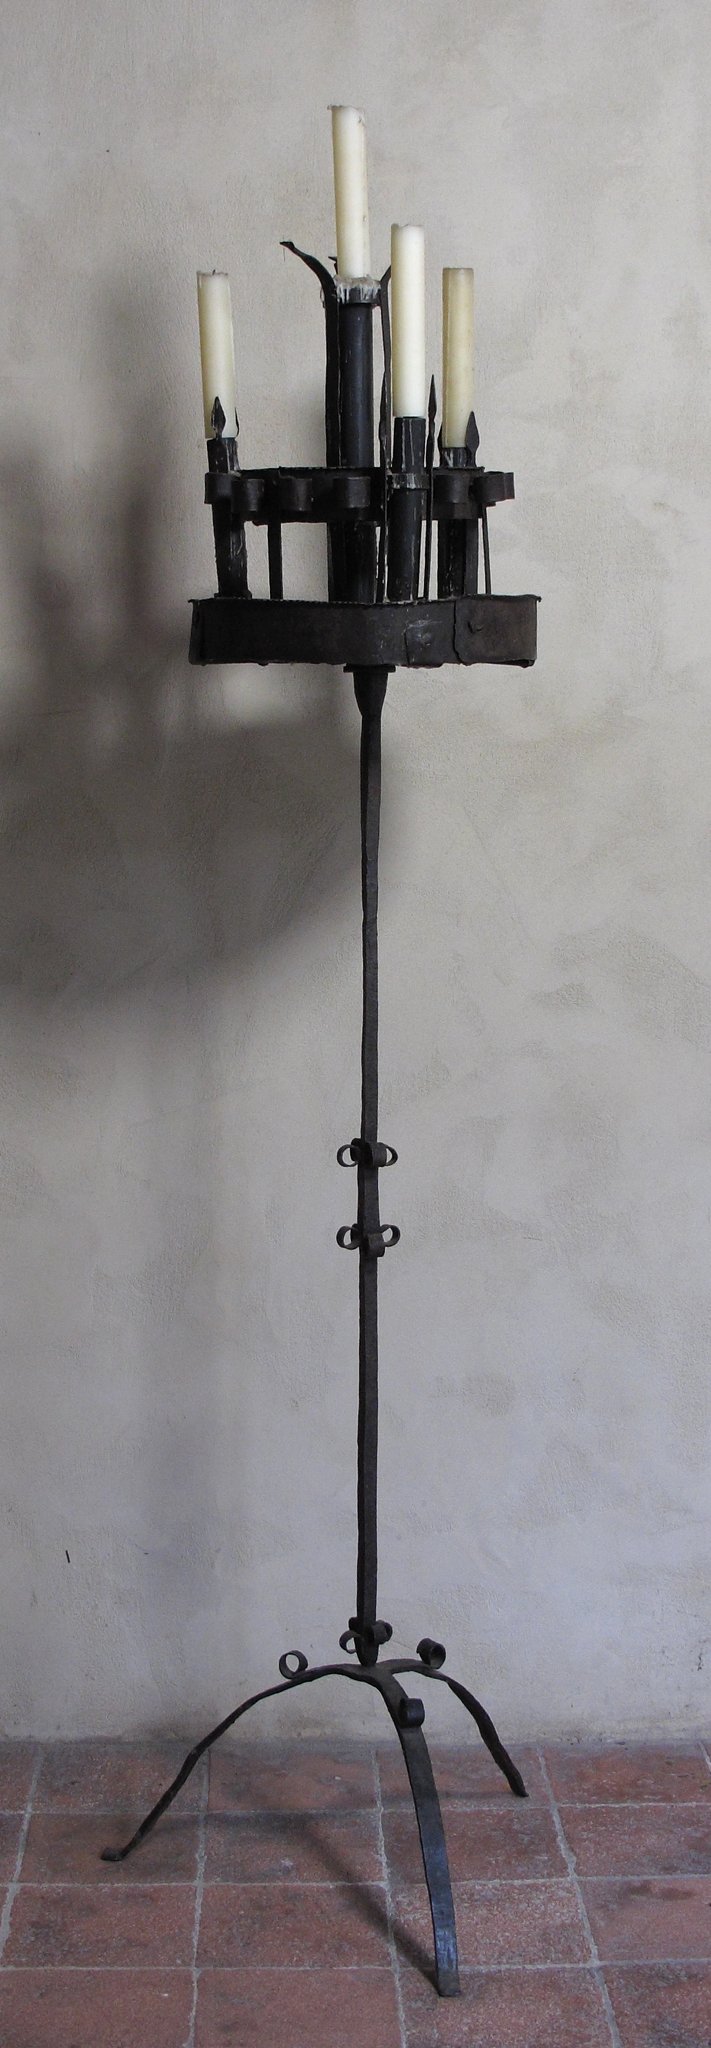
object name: candlestick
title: Pricket Candlestick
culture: european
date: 1501-1600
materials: iron